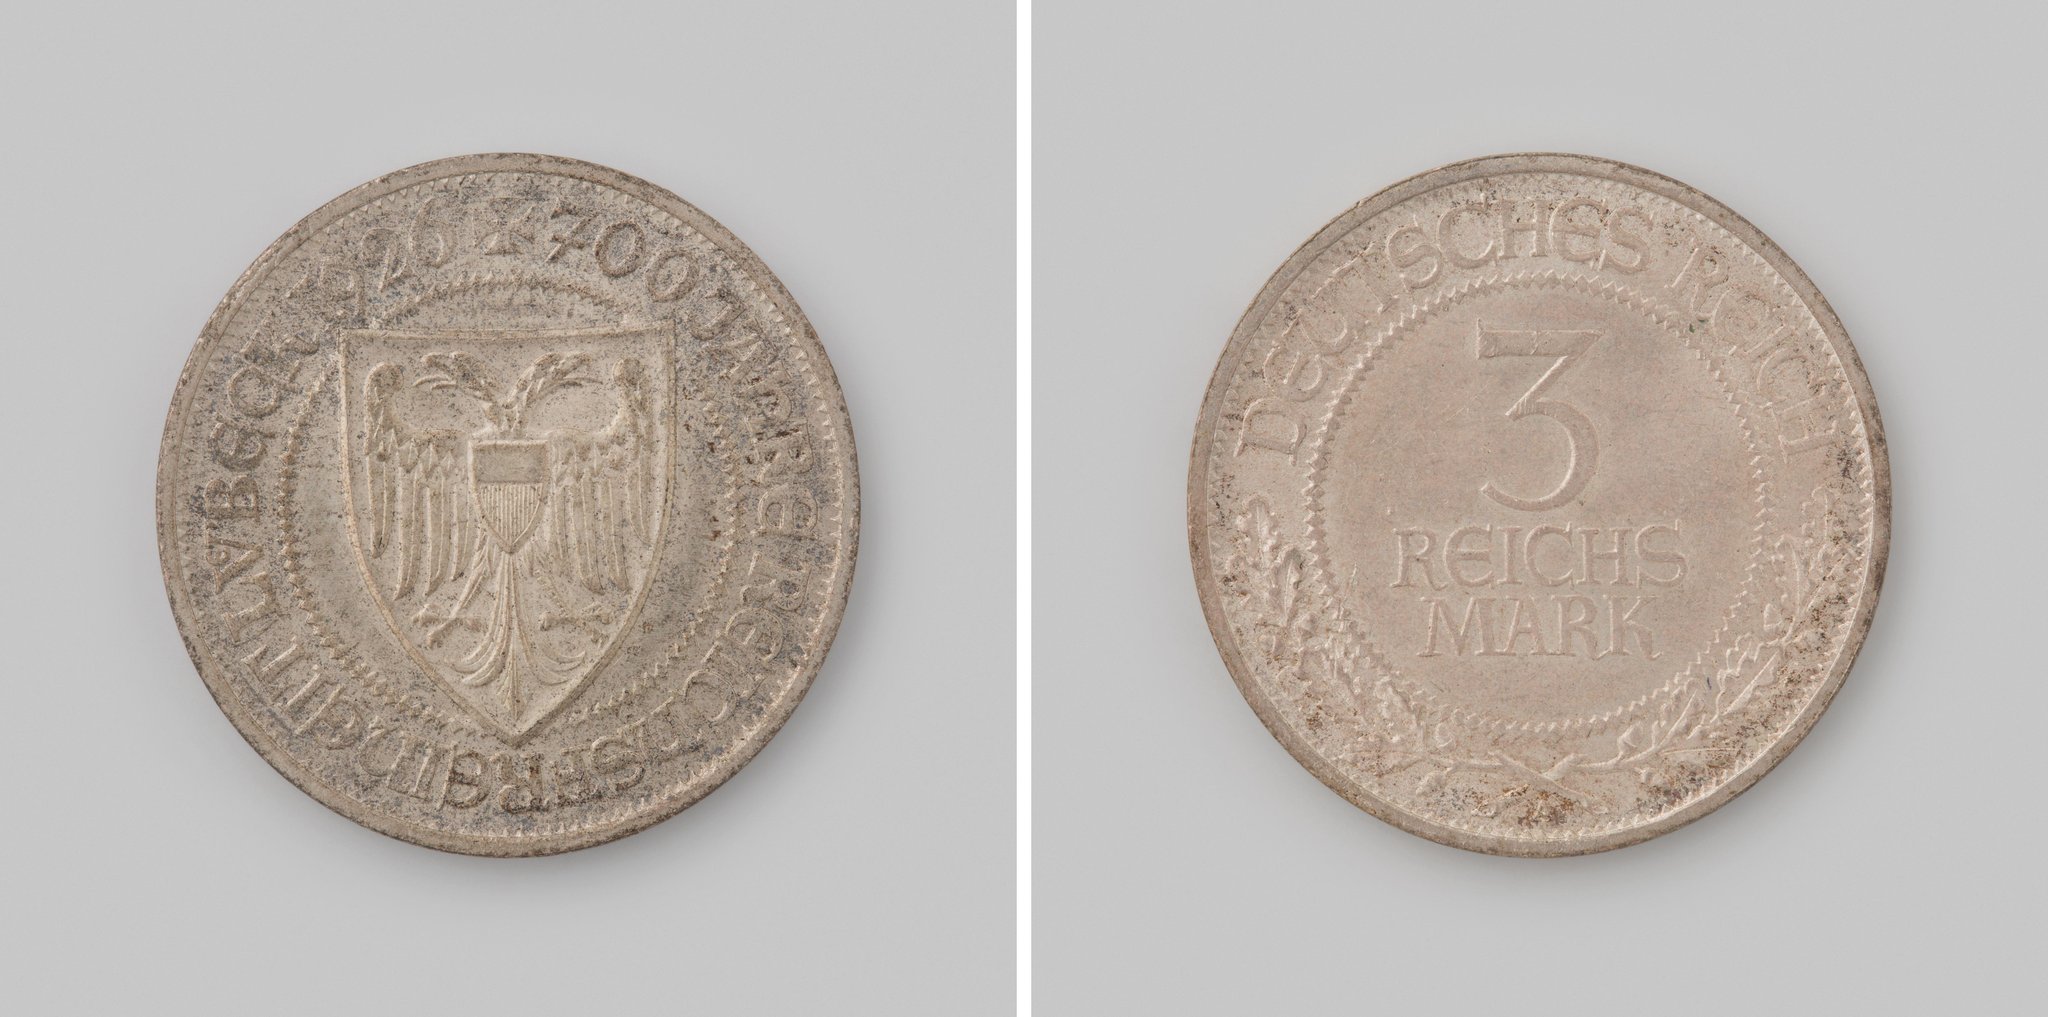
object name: drie reichsmark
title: 3 Reichsmark uit Duitsland, 1926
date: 1926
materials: silver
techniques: striking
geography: berlin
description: Zilveren herdenkingsmunt van het zevende eeuwfeest van de rijksvrijheid van Lübeck. Voorzijde: wapenschild. Jaartal in omschrift. Keerzijde: tussen twee samengebonden eiketakken waarde-aanduiding in drie regels. Onderaan letter A. Randschrift.